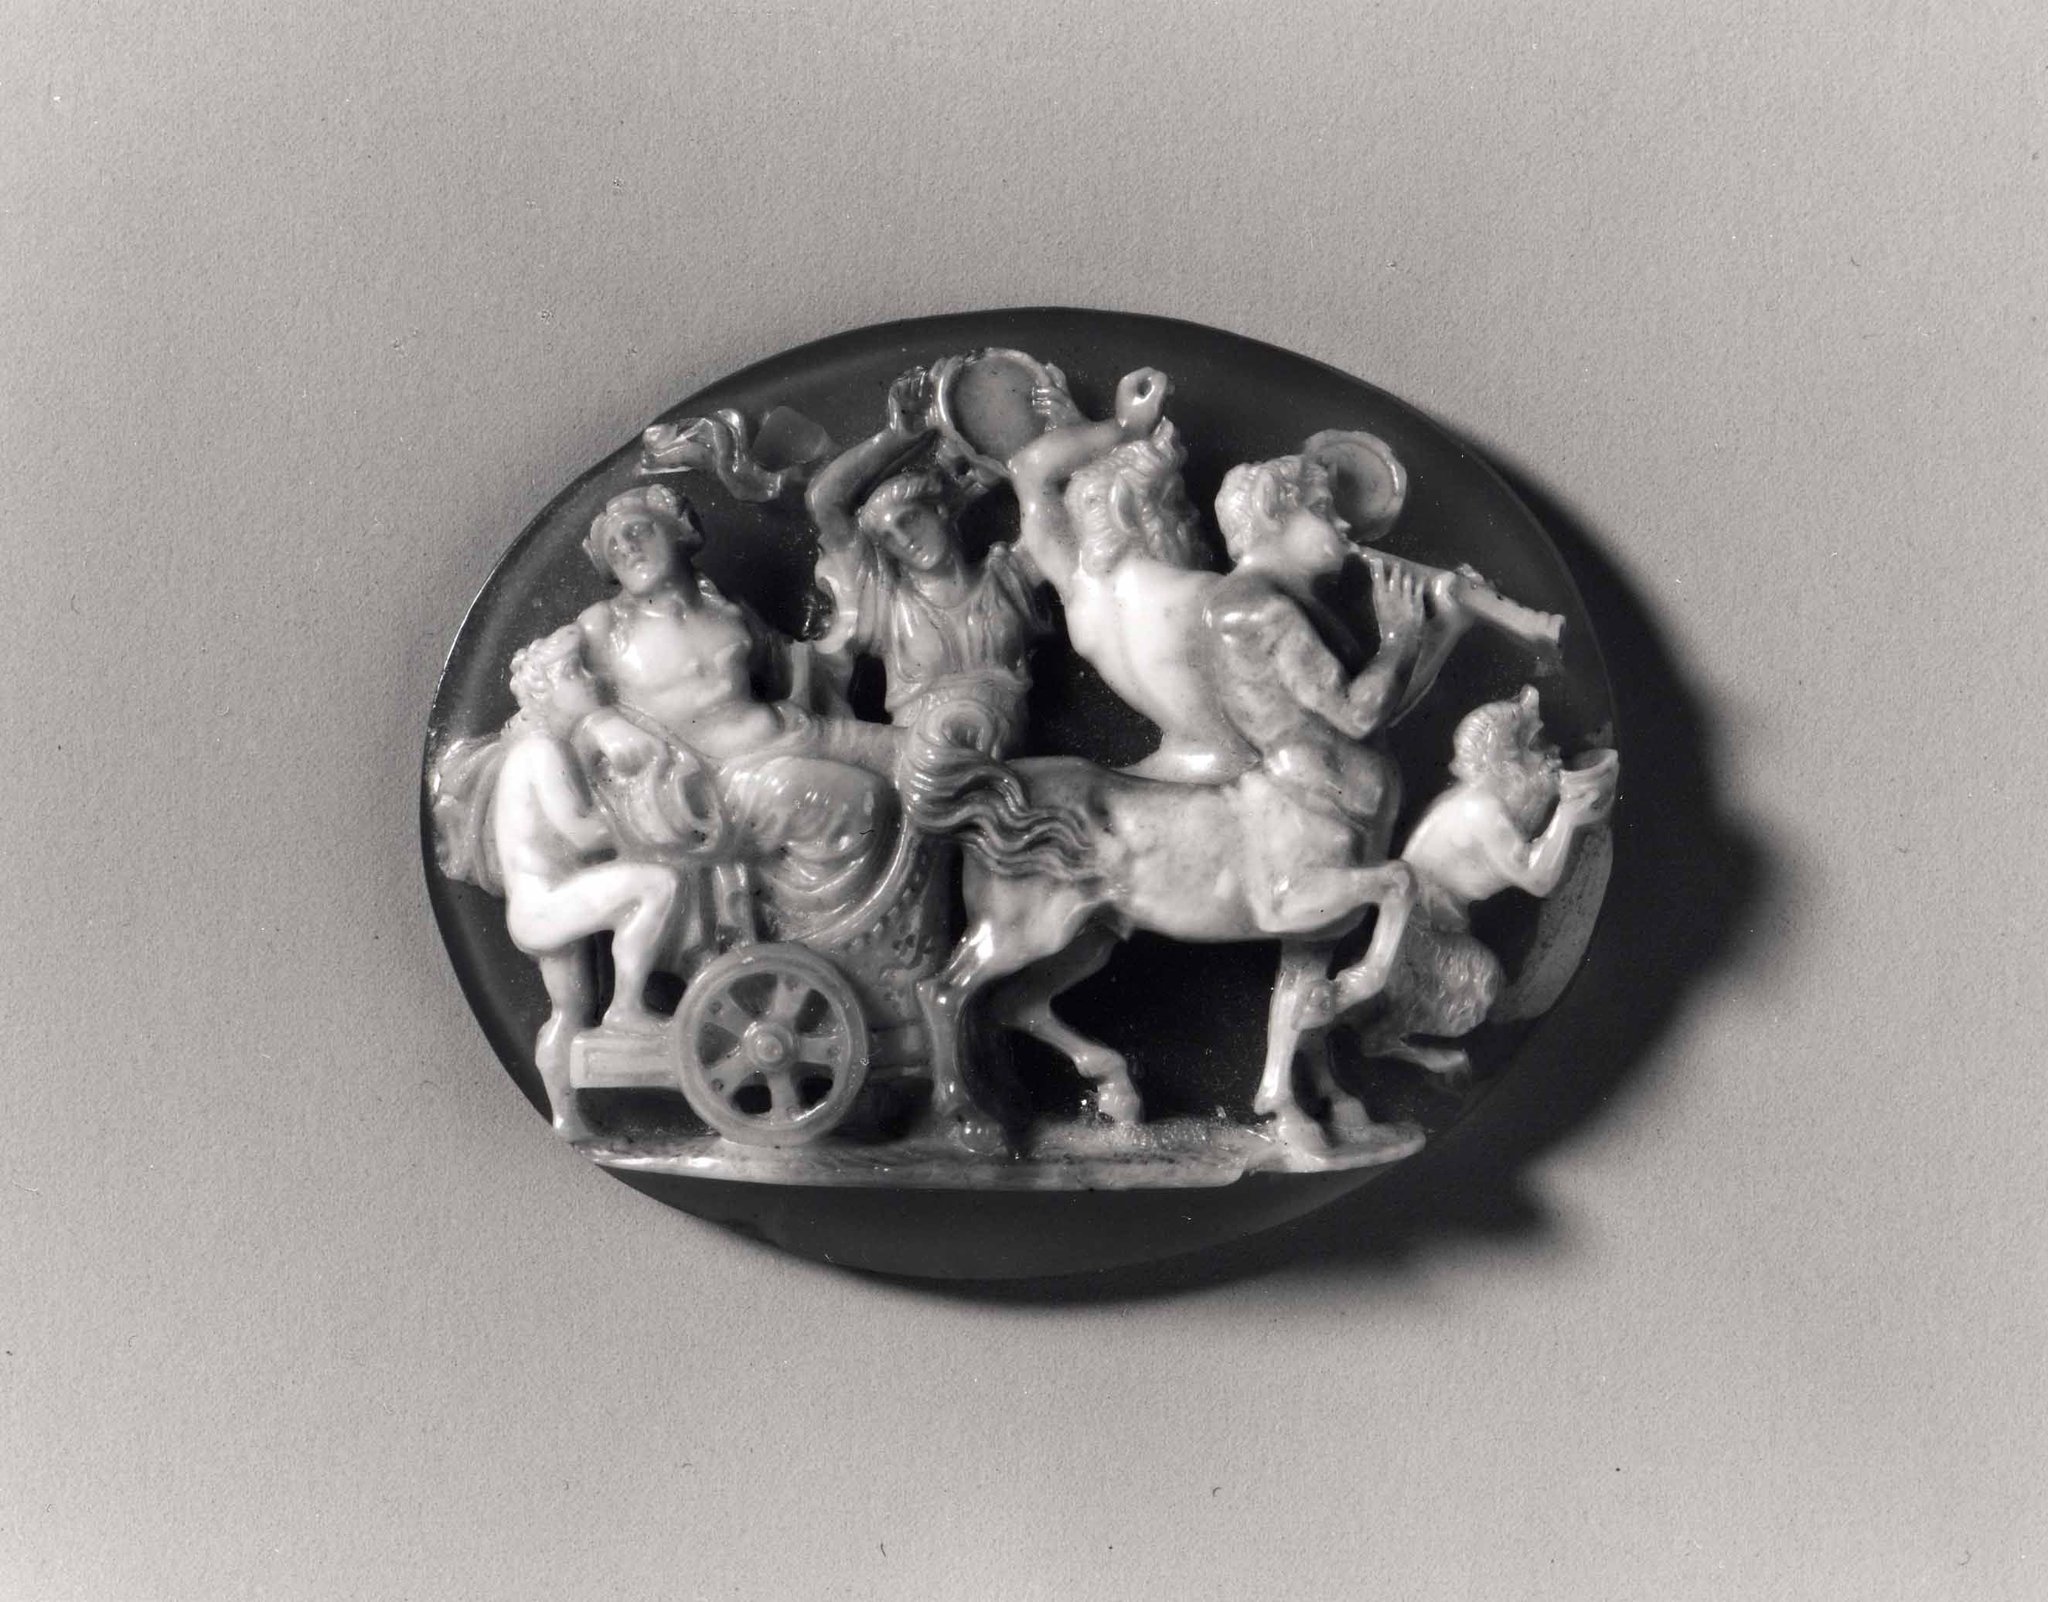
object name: cameo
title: Cameo with the Triumph of Bacchus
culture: austrian or italian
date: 1826-1850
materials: onyx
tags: men,centaurs,bacchus